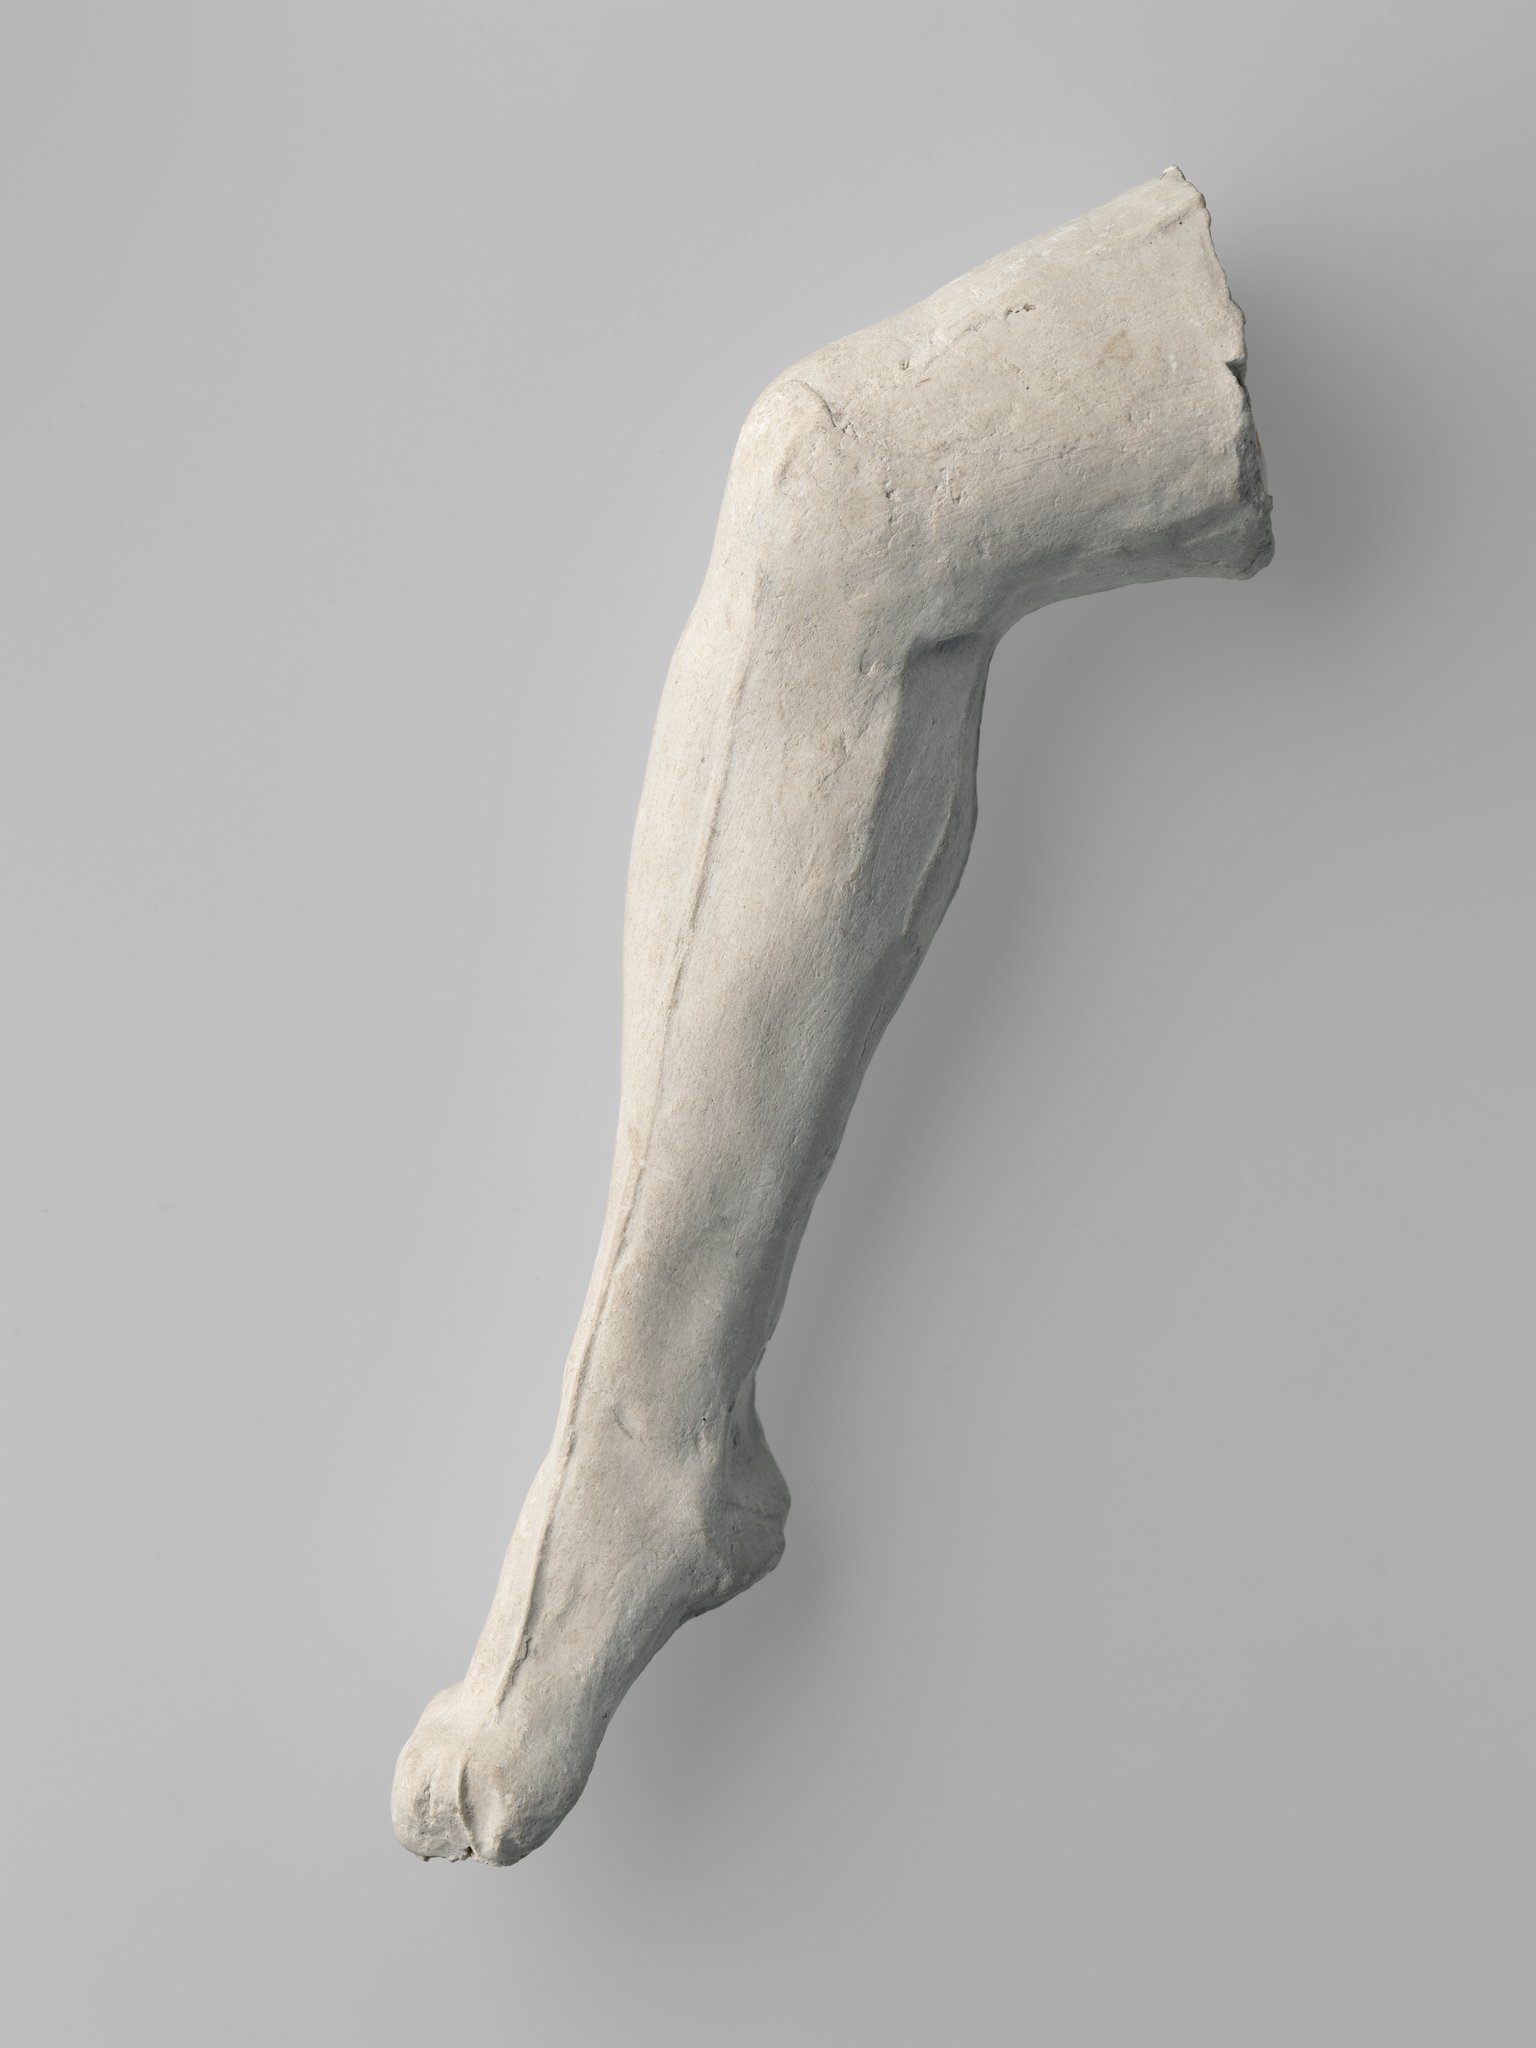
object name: cast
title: Study of a leg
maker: auguste rodin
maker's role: artist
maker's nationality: french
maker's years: 1840-1917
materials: plaster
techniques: casting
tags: legs